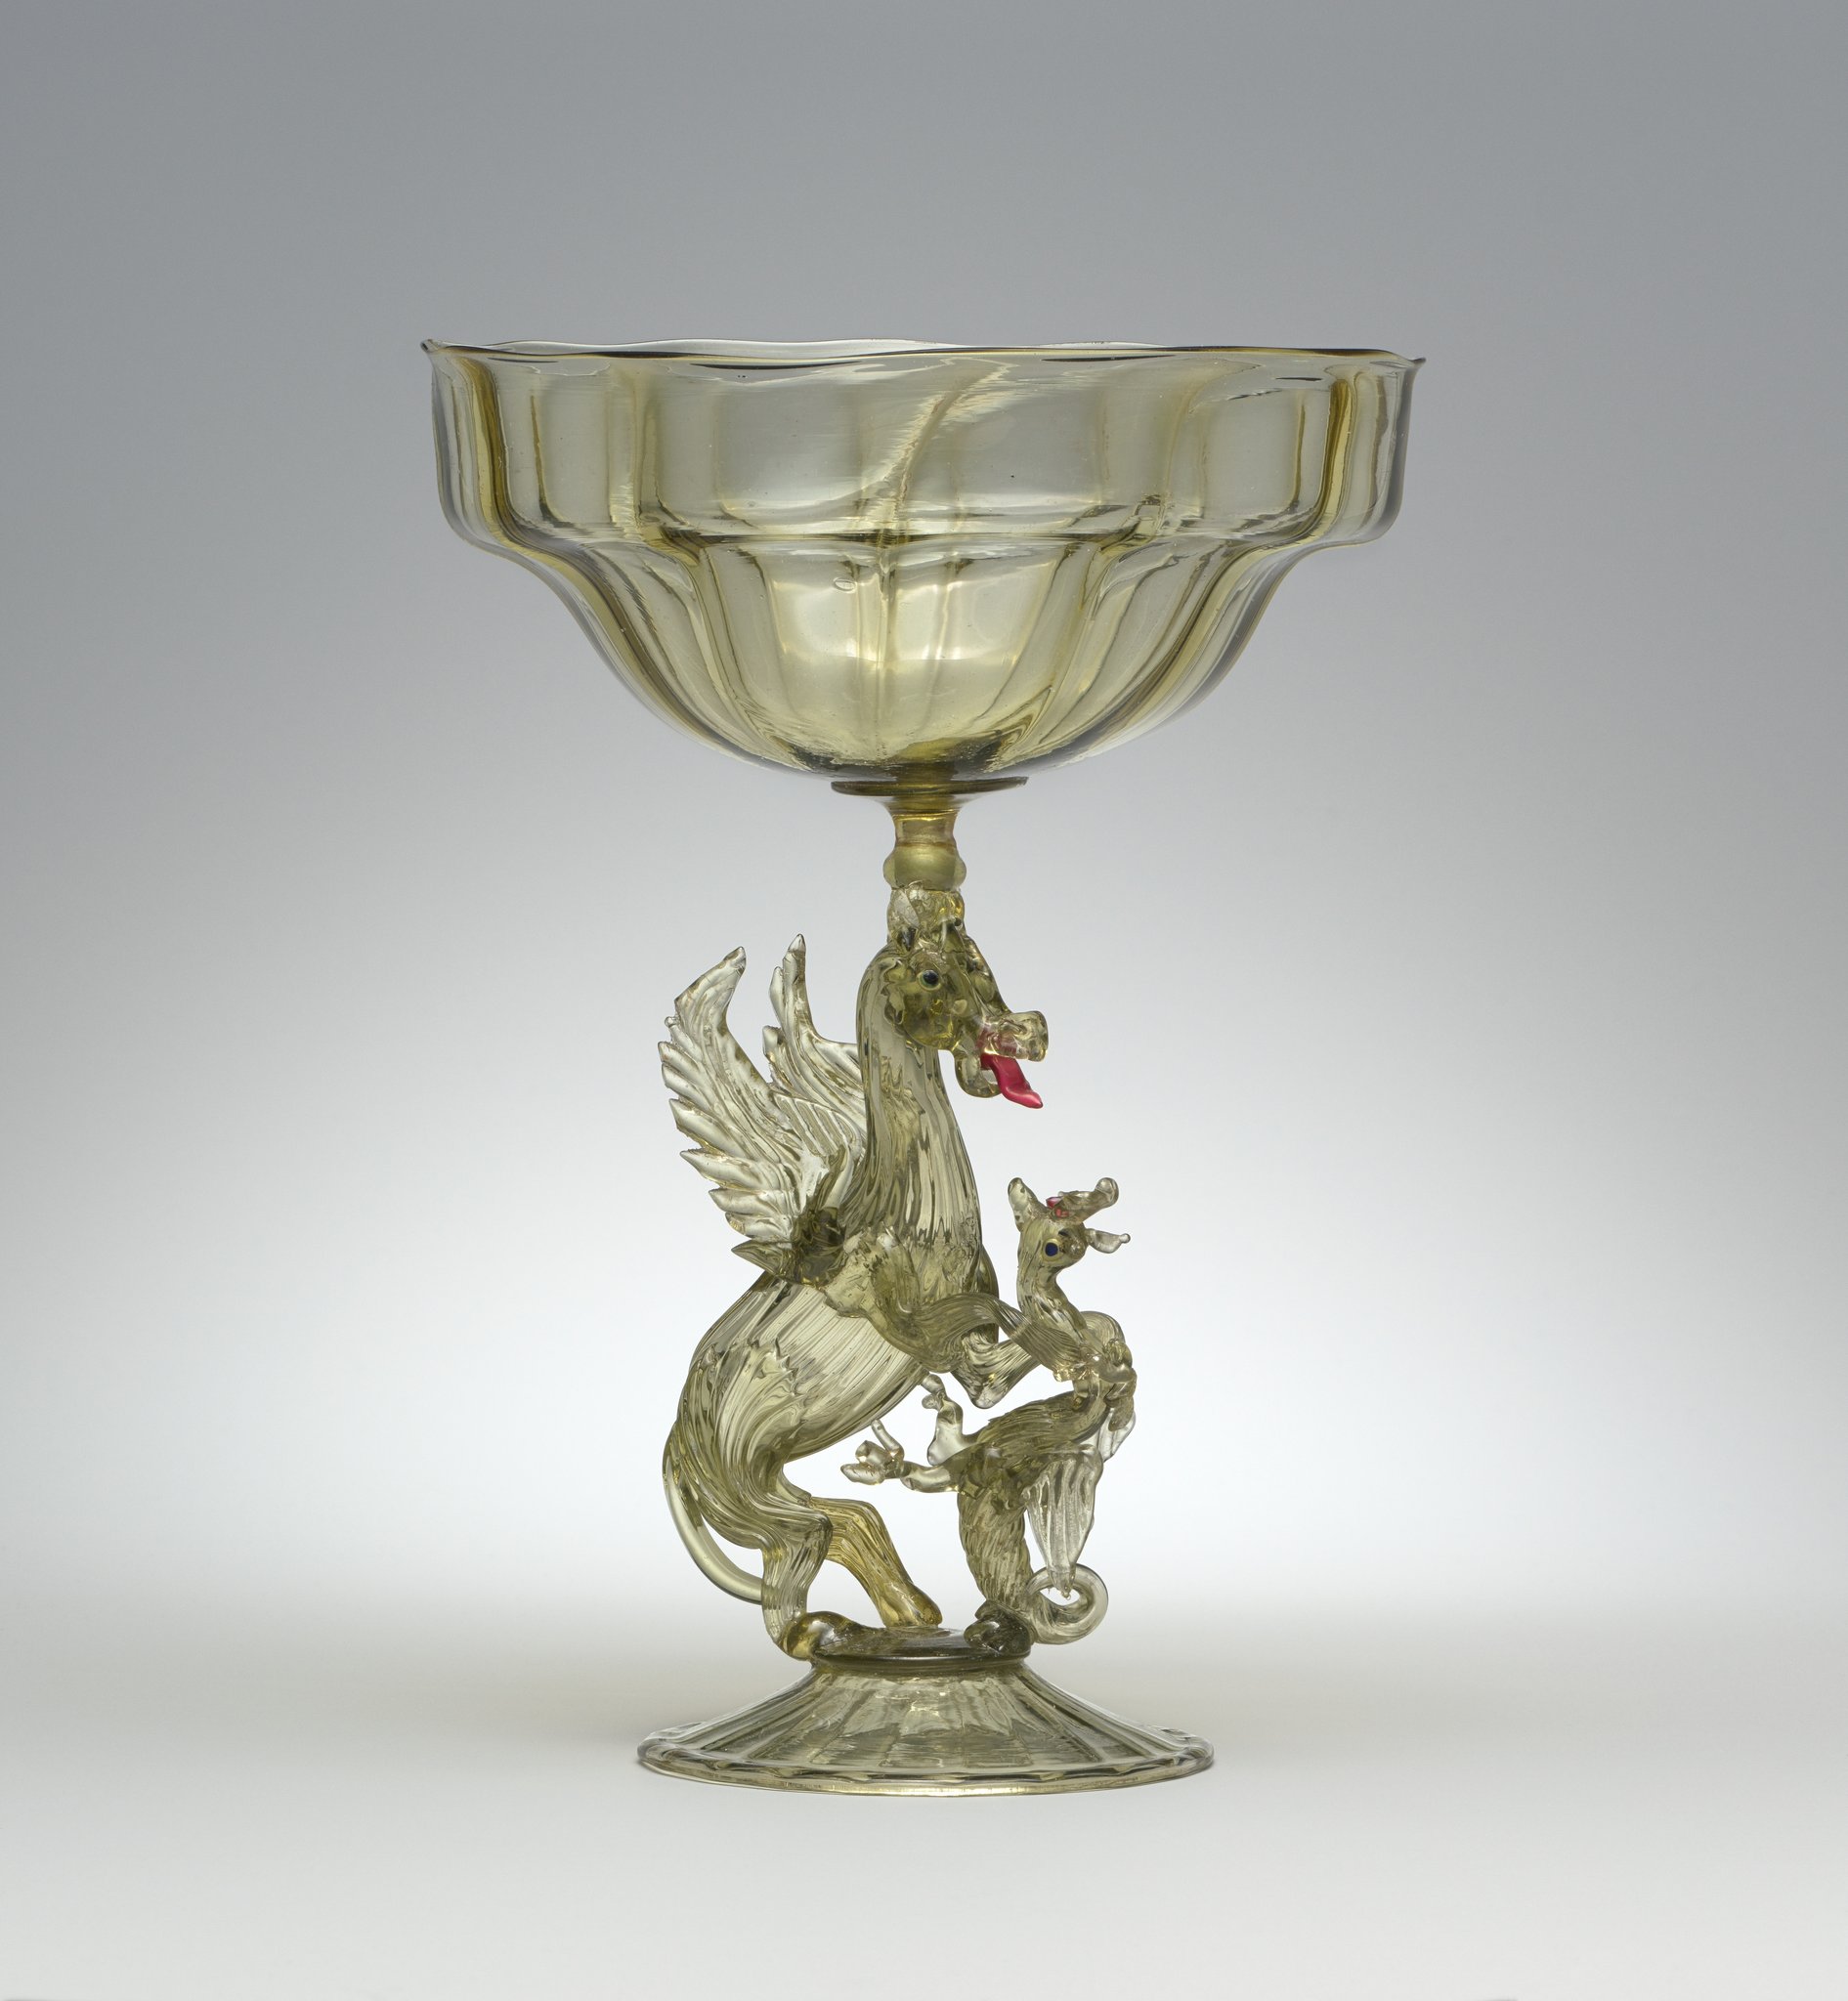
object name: standing cup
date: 1867-1900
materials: glass